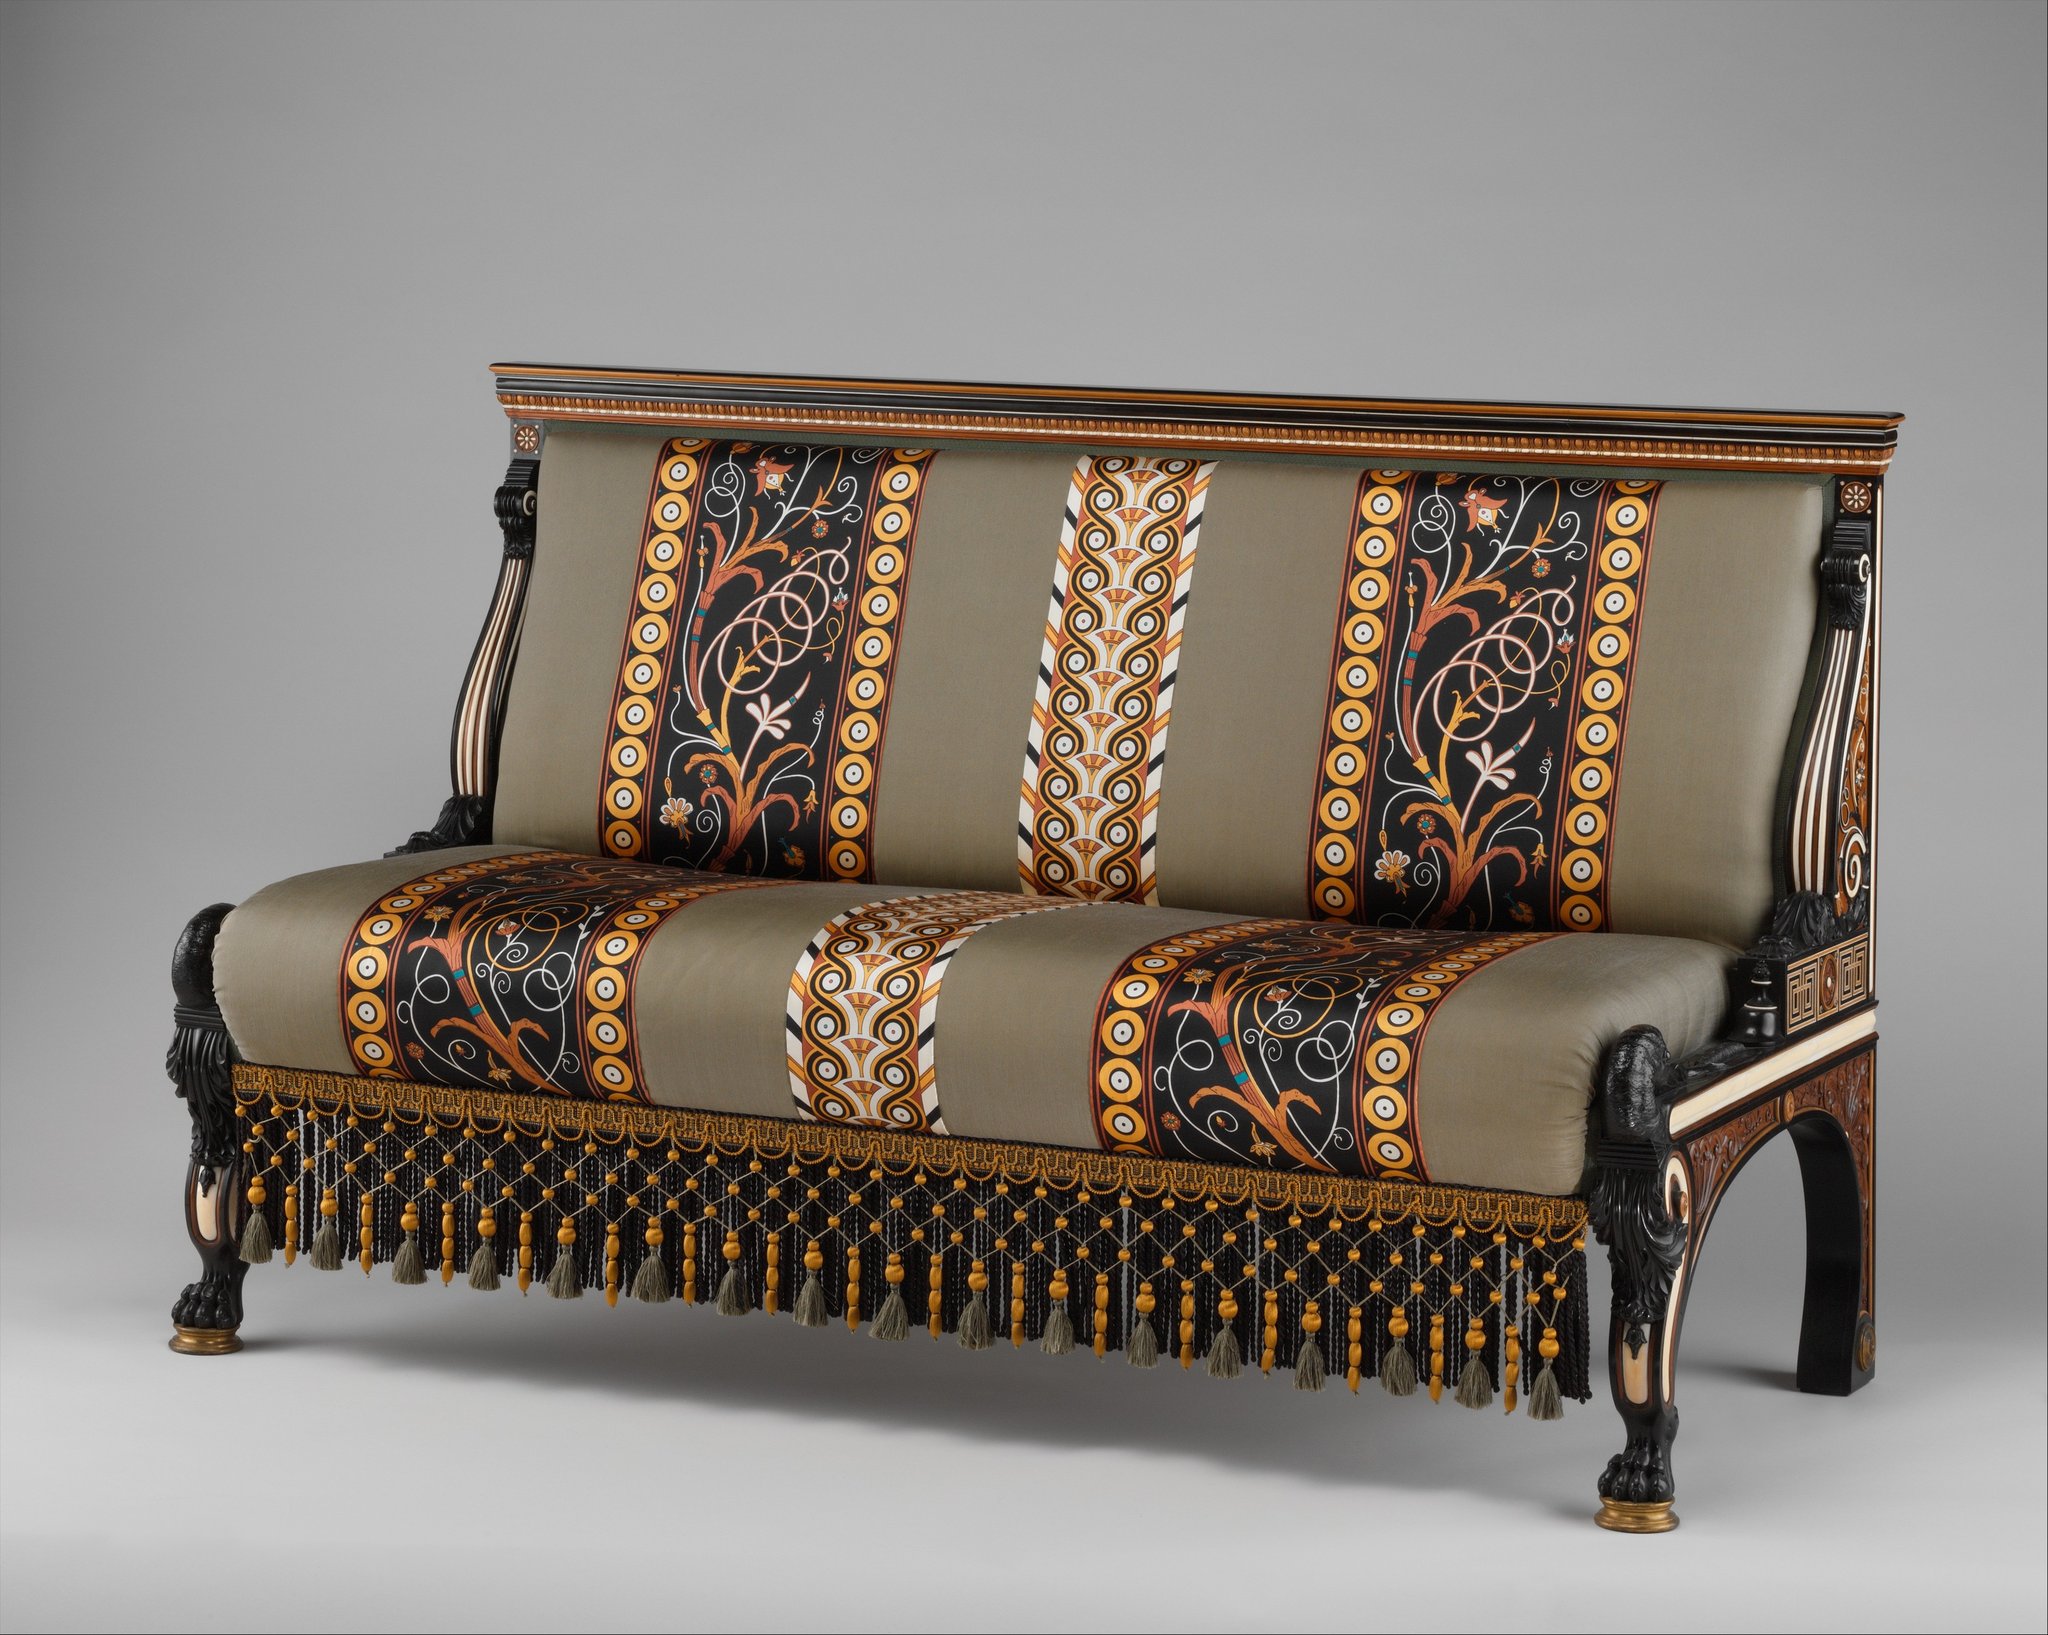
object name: settee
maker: sir lawrence alma-tadema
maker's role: designer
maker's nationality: british, born the netherlands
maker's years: 1836-1912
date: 1885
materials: brass, wood, ivory, mother of pearl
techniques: inlay